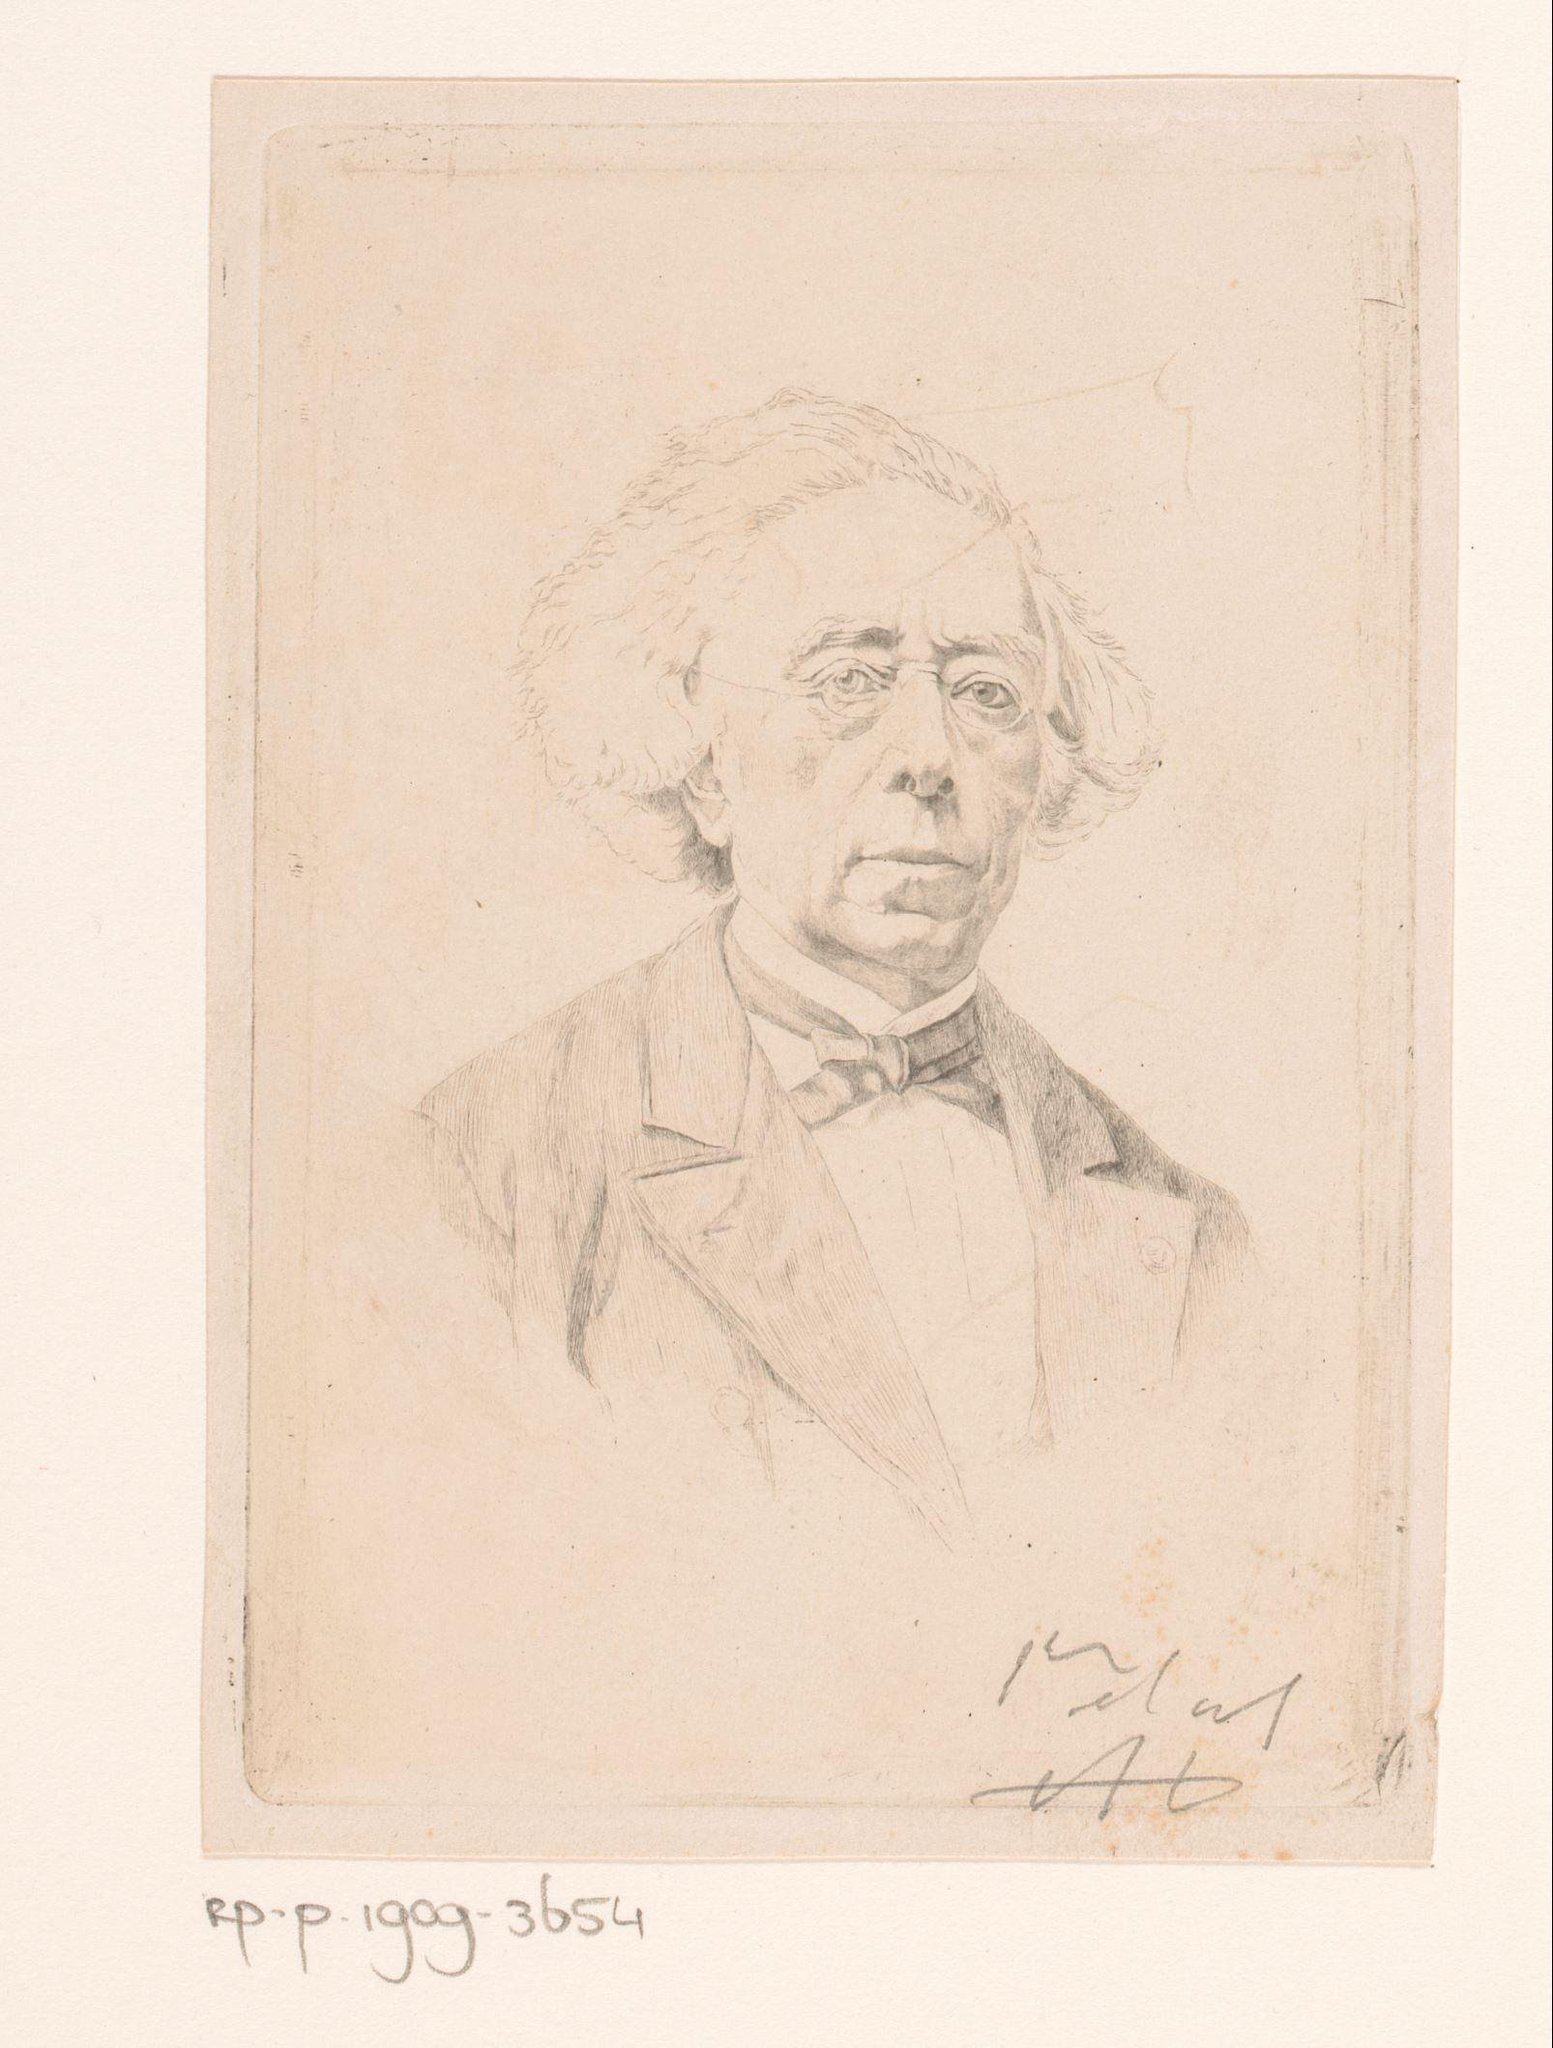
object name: print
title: Portret van Jean Joseph Thonissen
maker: auguste danse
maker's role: print maker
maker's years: 1829-1929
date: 1839-1909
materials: paper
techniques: etching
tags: louvain, politician, jean-joseph thonissen, historical person (...) - historical person (...) portrayed alone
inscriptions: annotation: ‘1er état’, collector's mark: Lugt 2228